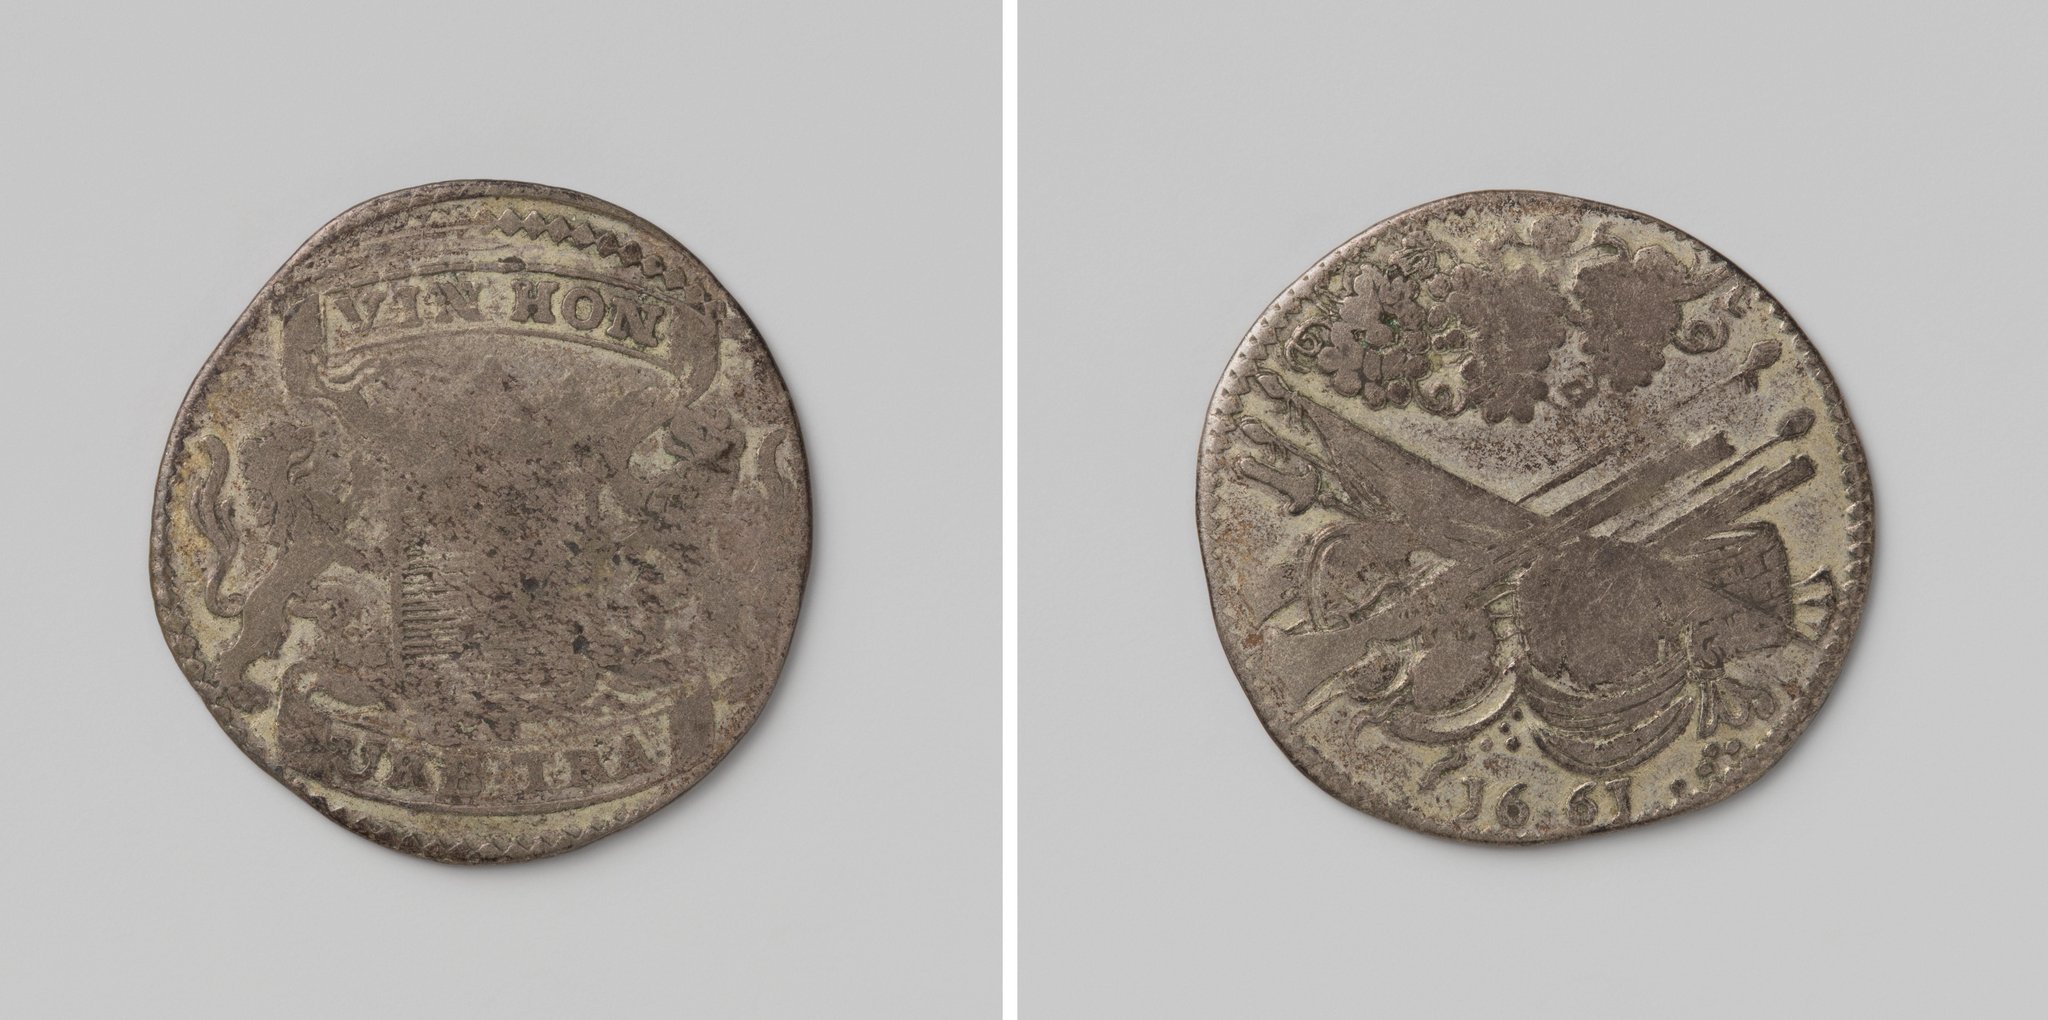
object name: marksman medal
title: Schutterij van Utrecht, penning die schutters recht gaf op een kan wijn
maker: roelof van cuylenburch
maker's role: goldsmith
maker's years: 1607-1673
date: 1661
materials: silver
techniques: striking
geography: utrecht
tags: utrecht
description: Zilveren wijn- en schutterspenning van Utrecht. Voorzijde: gekroond wapenschild, geflankeerd door twee leeuwen onder en boven wimpel met opschrift. Keerzijde: druiventros boven wapentrophee bestaande uit harnas, vaandels, trom en wapentuig; daaronder: jaartal